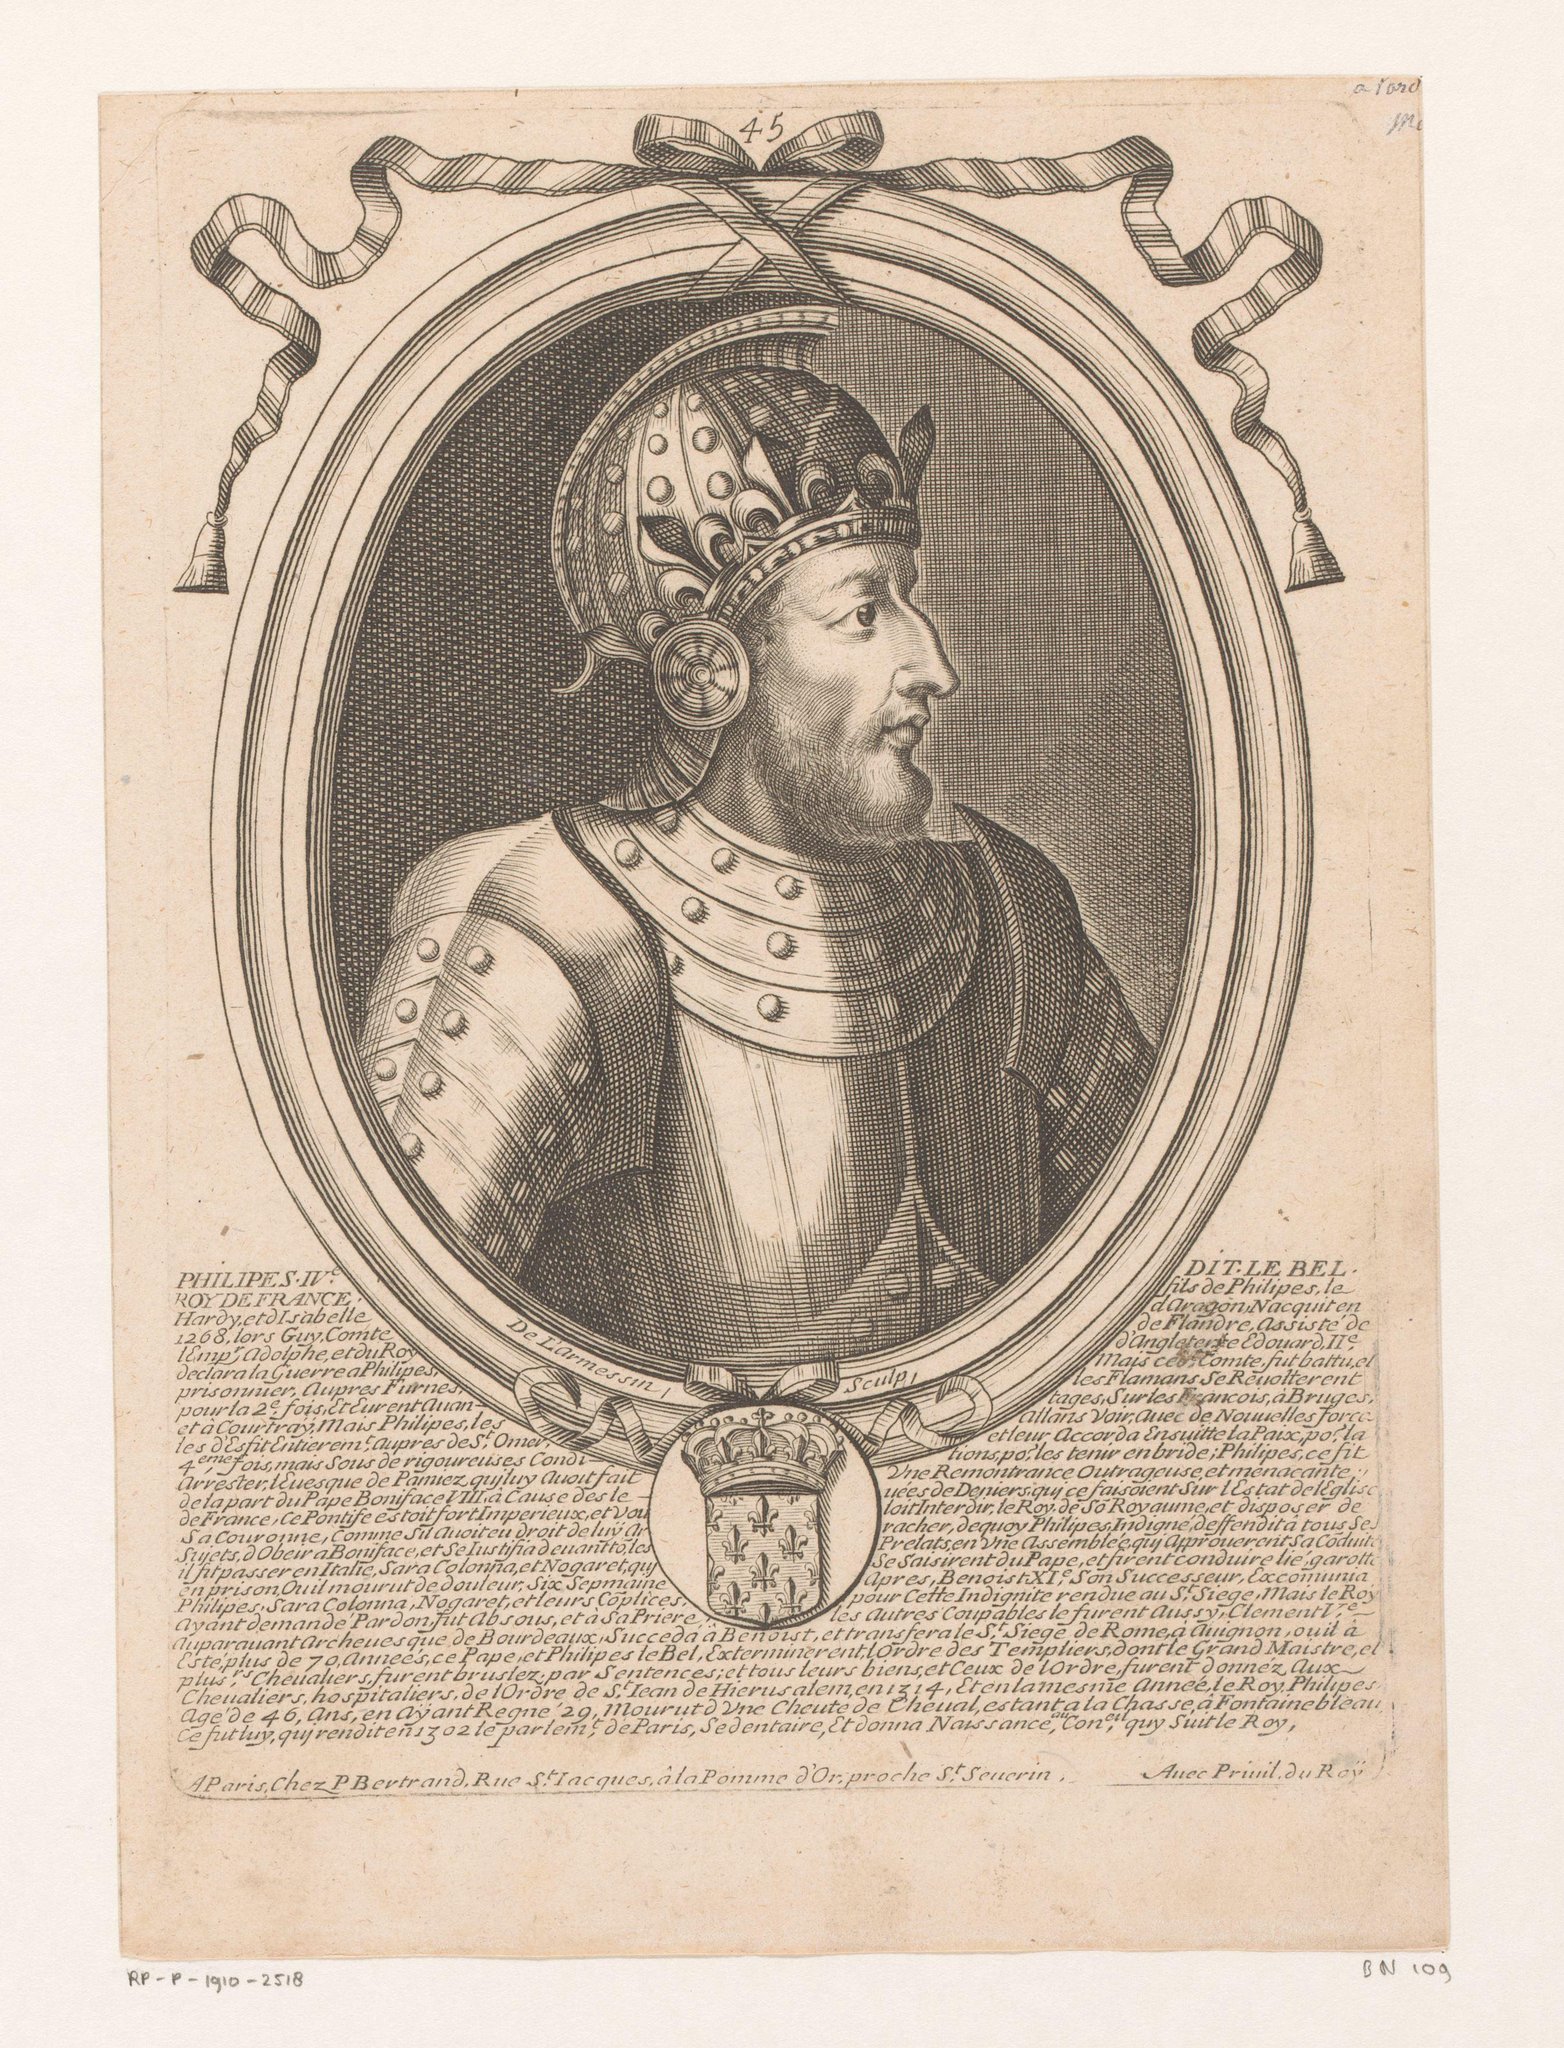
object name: print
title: Philips IV dit Le Bel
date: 1642-1678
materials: paper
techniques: engraving, etching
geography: paris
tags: historical persons, king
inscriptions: collector's mark: Lugt 2228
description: Maakt deel uit van een grootschalige serie met portretten van prominente figuren. Binnen de serie bevindt zich een sectie getiteld 'Les Augustes Représentations De tous les Roys De France depuis Pharamond Iusqu'à Louys XIIII'. De serie werd respectievelijk uitgegeven door Pierre Bertrand, door zijn weduwe en door De Larmessin zelf.